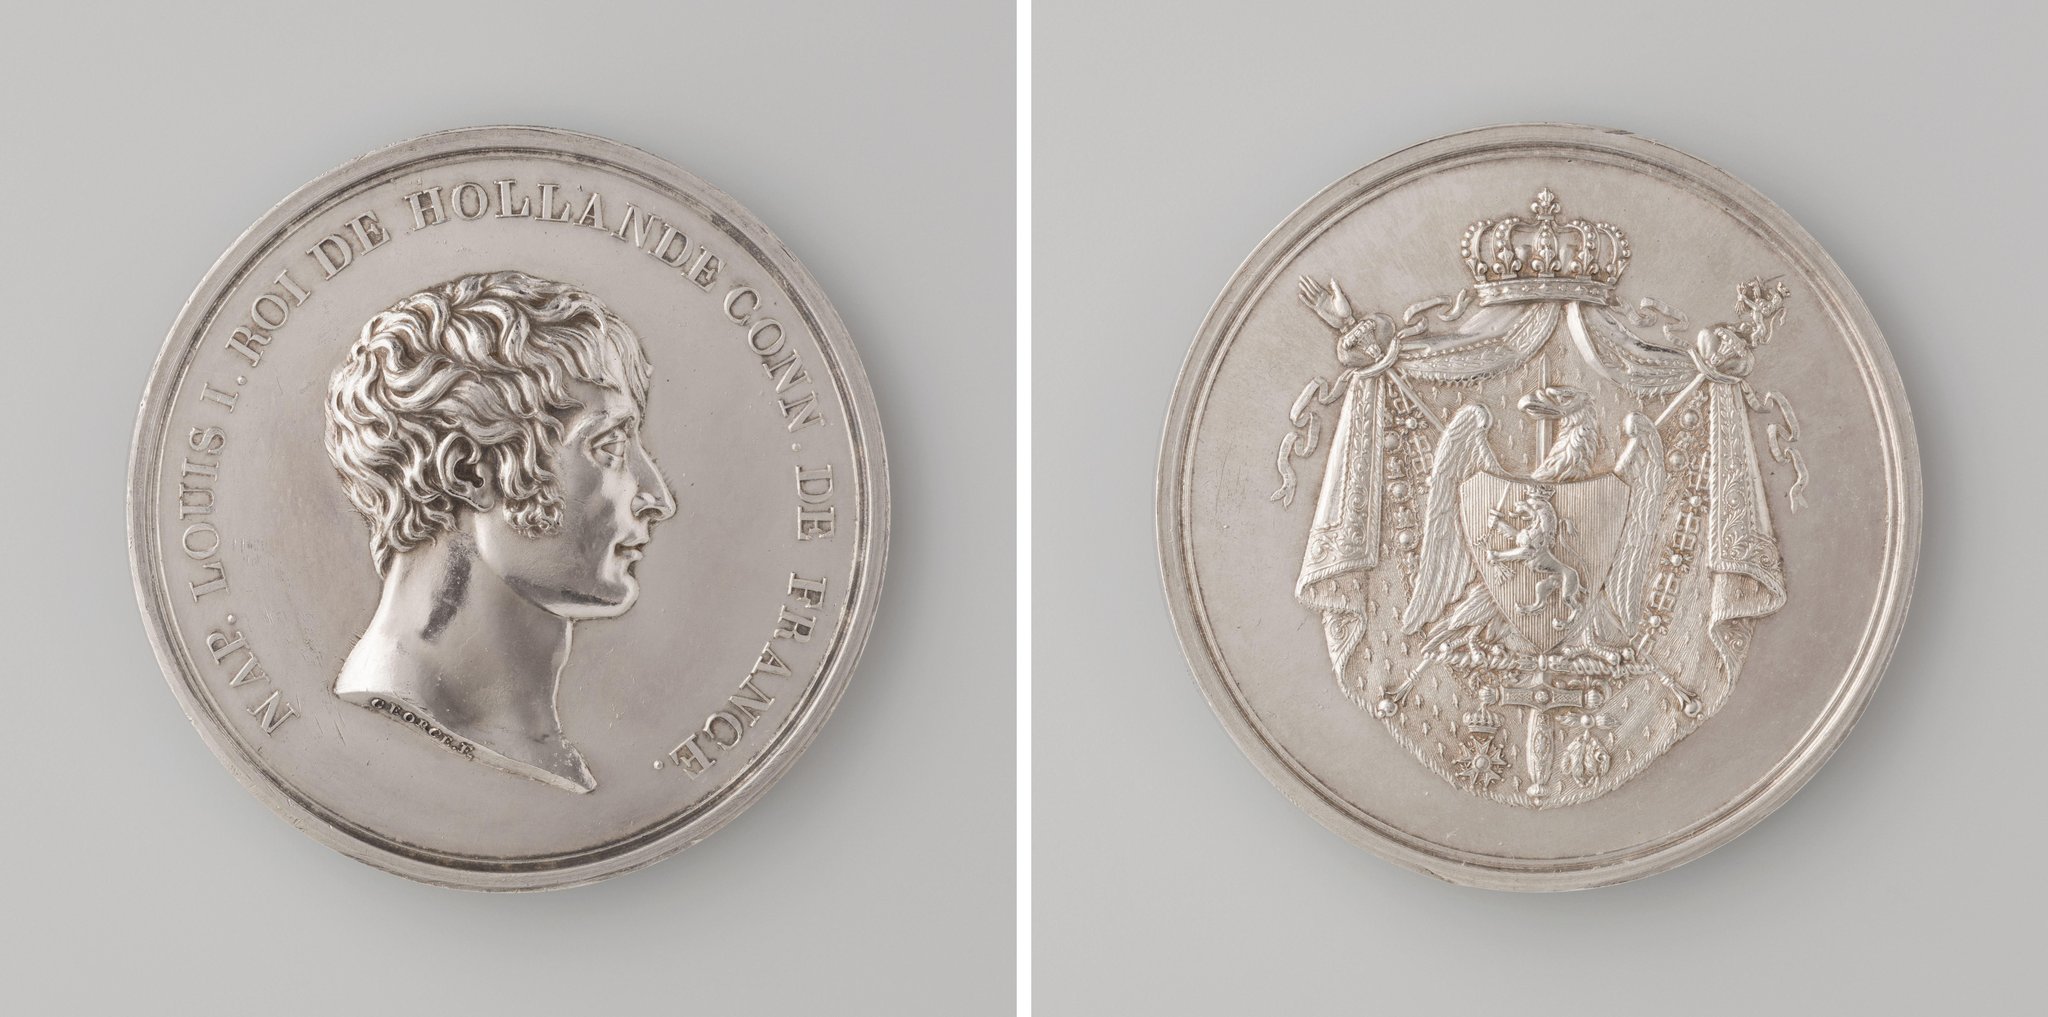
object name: history medal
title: Lodewijk Napoleon, koning van Holland, connetable de France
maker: george (medailleur)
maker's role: medailleur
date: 1806-1810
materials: silver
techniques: striking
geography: utrecht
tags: louis napoleon (king of holland)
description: Zilveren penning. Voorzijde: borststuk man binnen omschrift. Keerzijde: gekroond wapenschild